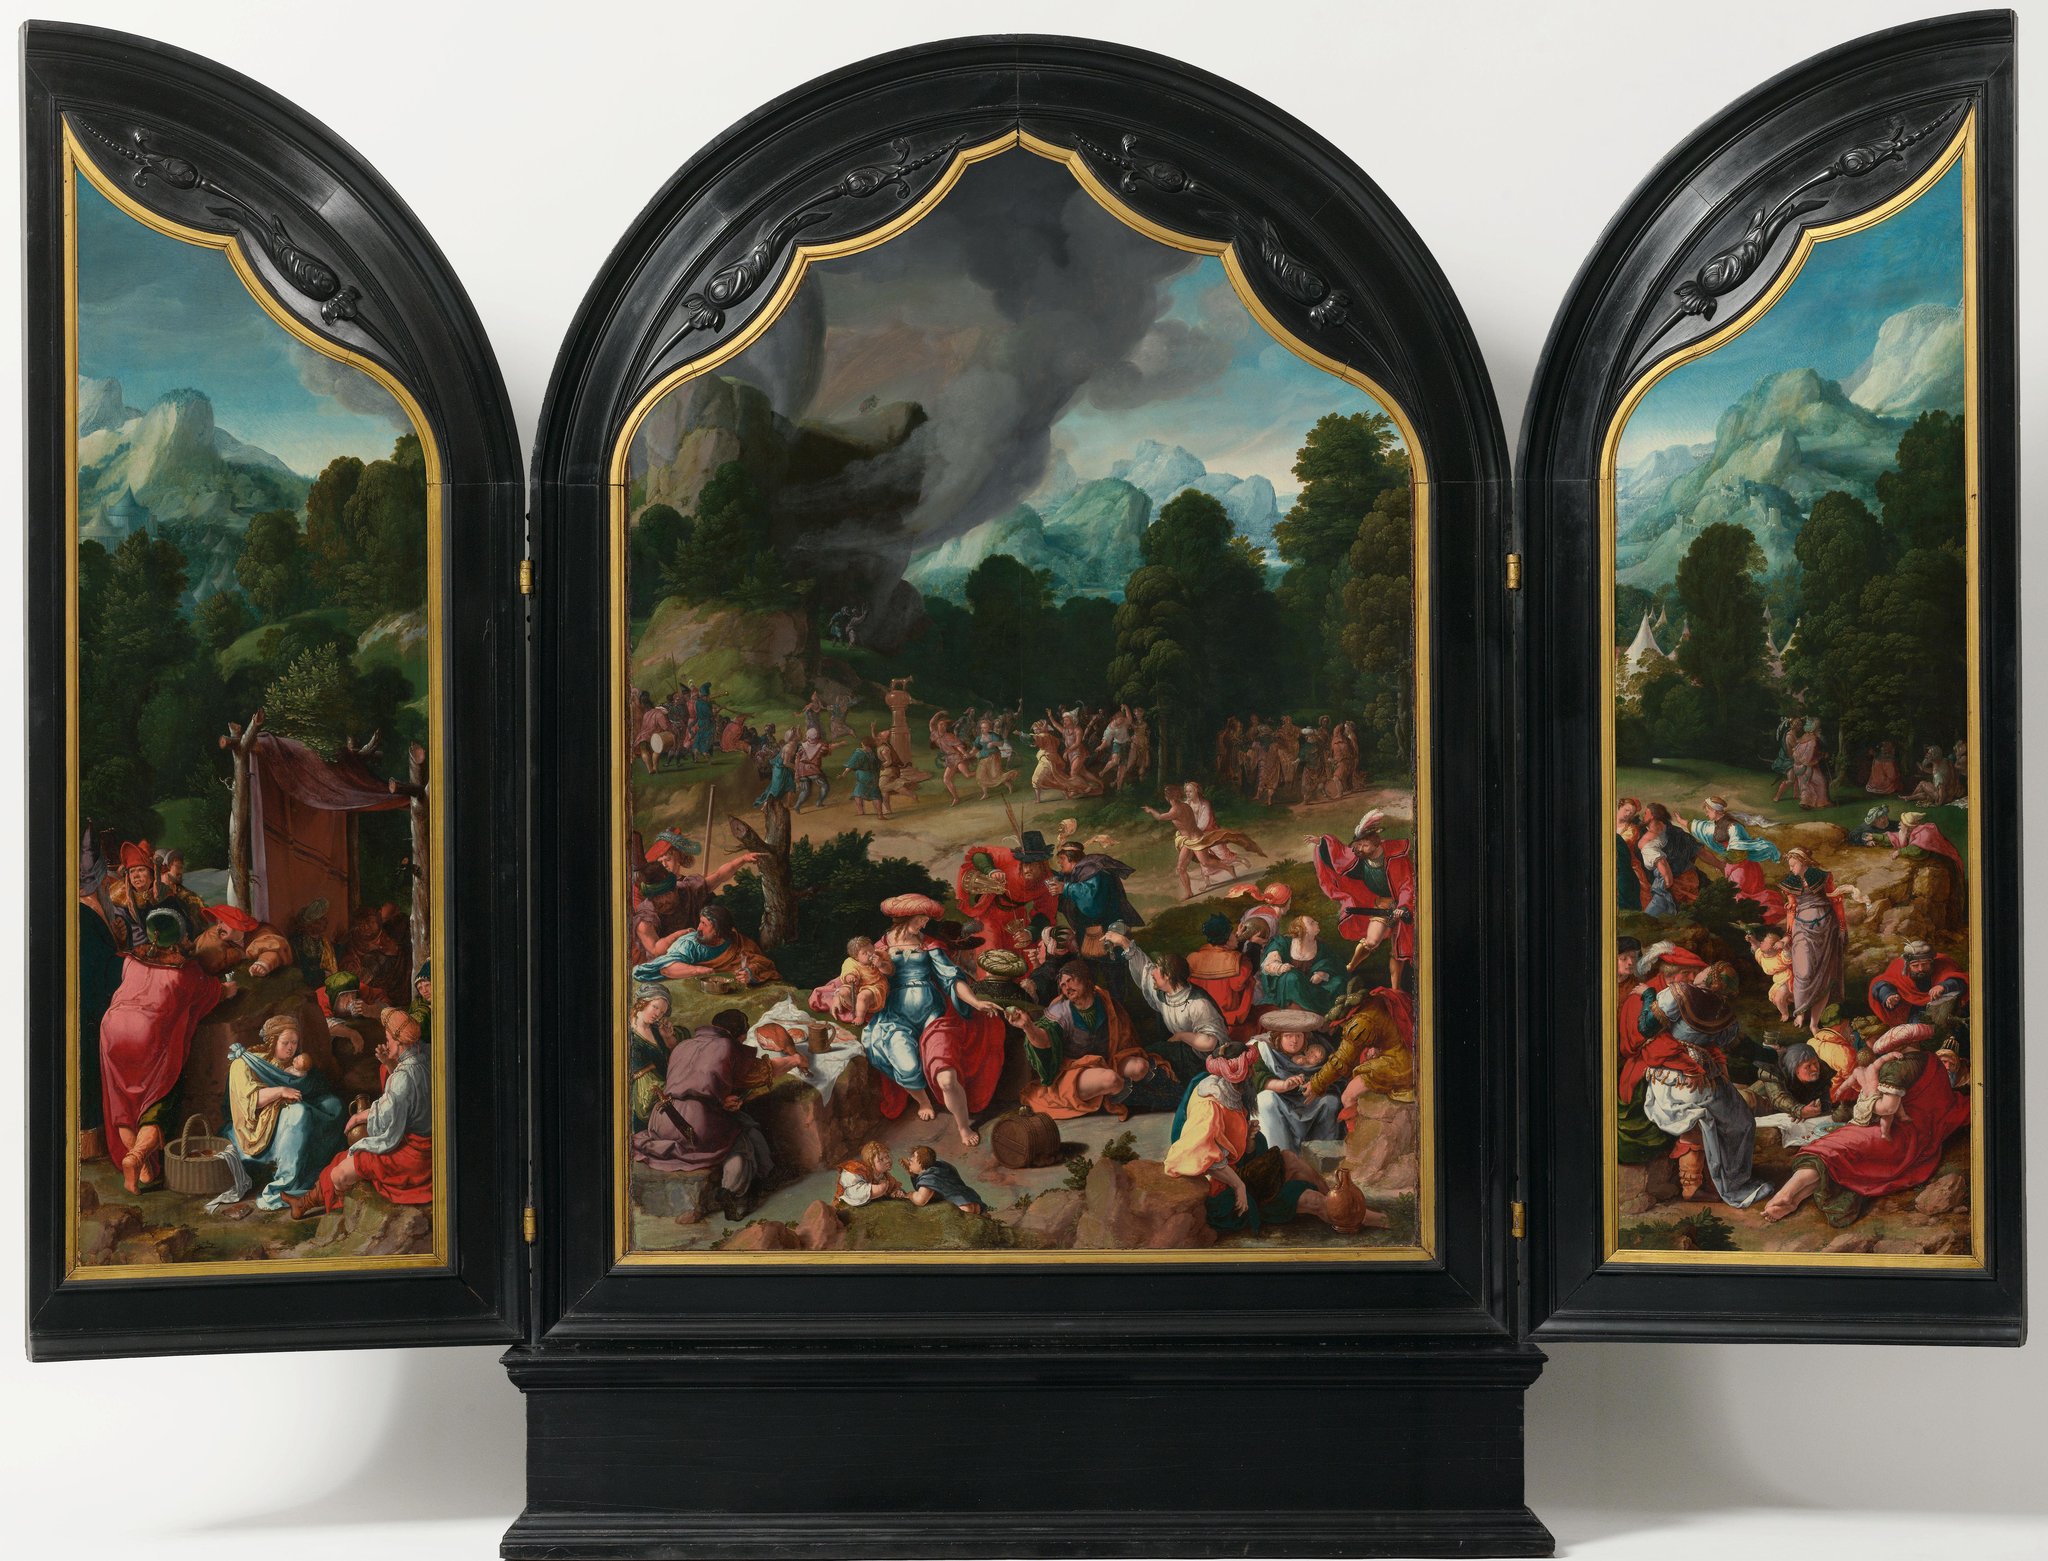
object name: painting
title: Triptych with the Adoration of the Golden Calf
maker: lucas van leyden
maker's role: draughtsman, painter, print maker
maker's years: 1494-1533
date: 1530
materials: oil, panel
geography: leiden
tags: celebration meal, feast, banquet, (lovers) caressing each other, moses on mount sinai with the tables of the law (exodus 24:9-18, 31:18), the people dance around the golden calf ~ exodus, the people feasting ~ adoration of the golden calf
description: This biblical narrative, showing the Israelites who were disloyal to God by worshipping the golden statue of a calf, was set by Lucas van Leyden in a continuous landscape. The triptych warns against faithlessness and debauchery. The choice of this rare subject is perhaps connected to the rise of Protestantism, with its strong aversion to the Roman Catholic veneration of religious images.